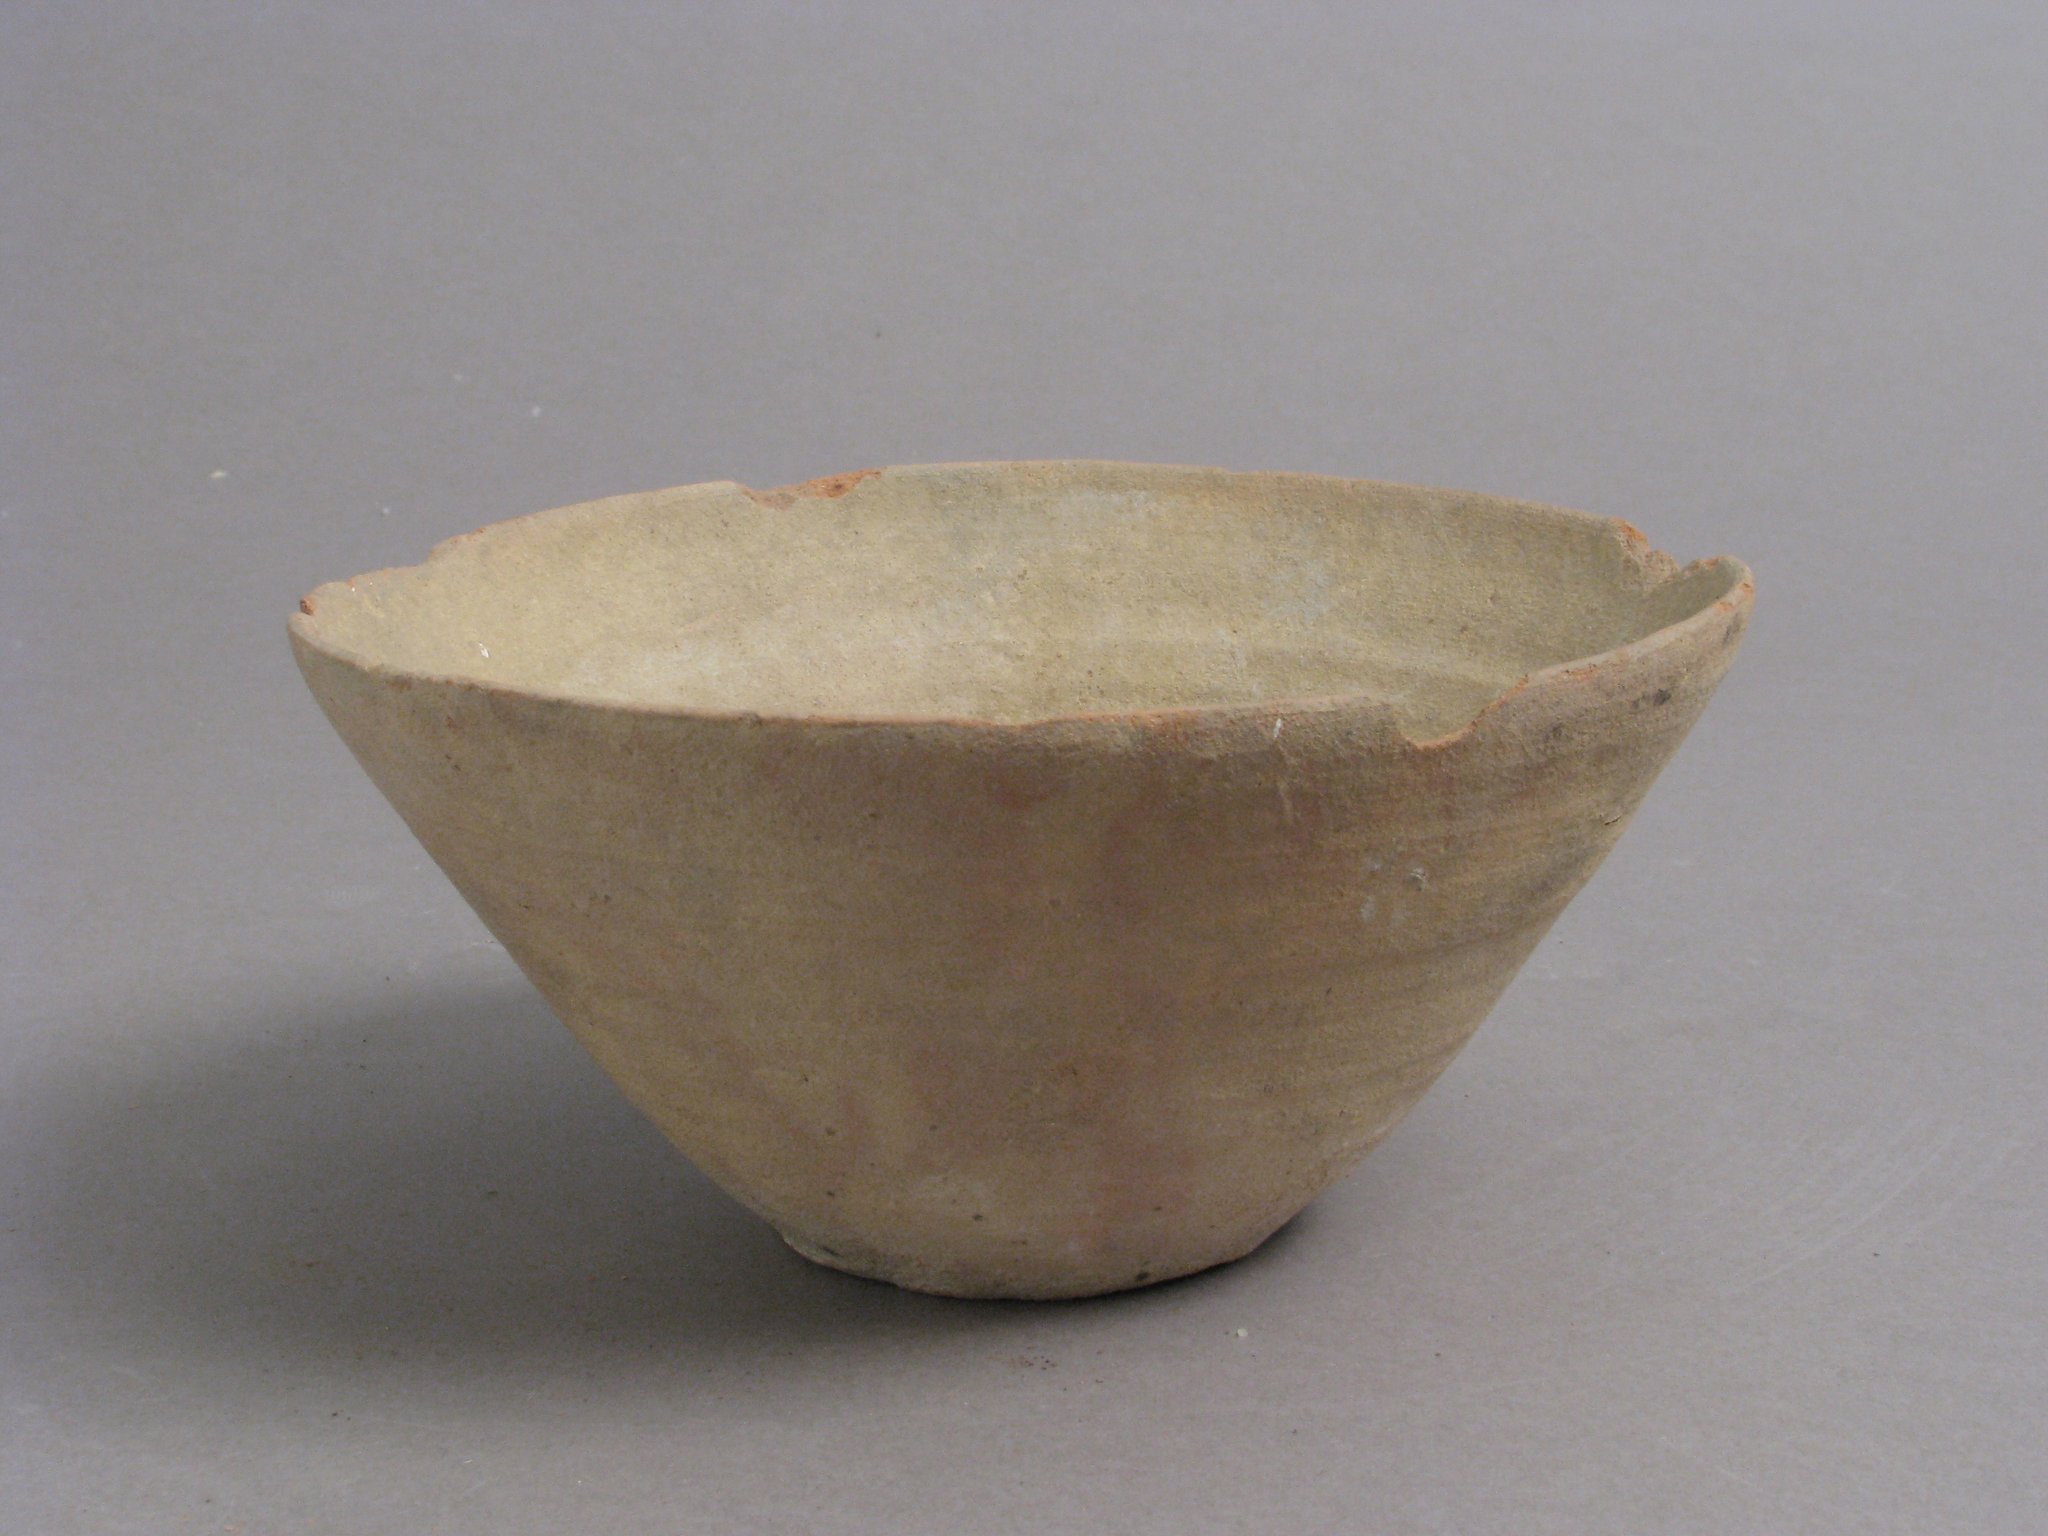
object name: bowl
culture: coptic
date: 301-700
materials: earthenware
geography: egypt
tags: bowls